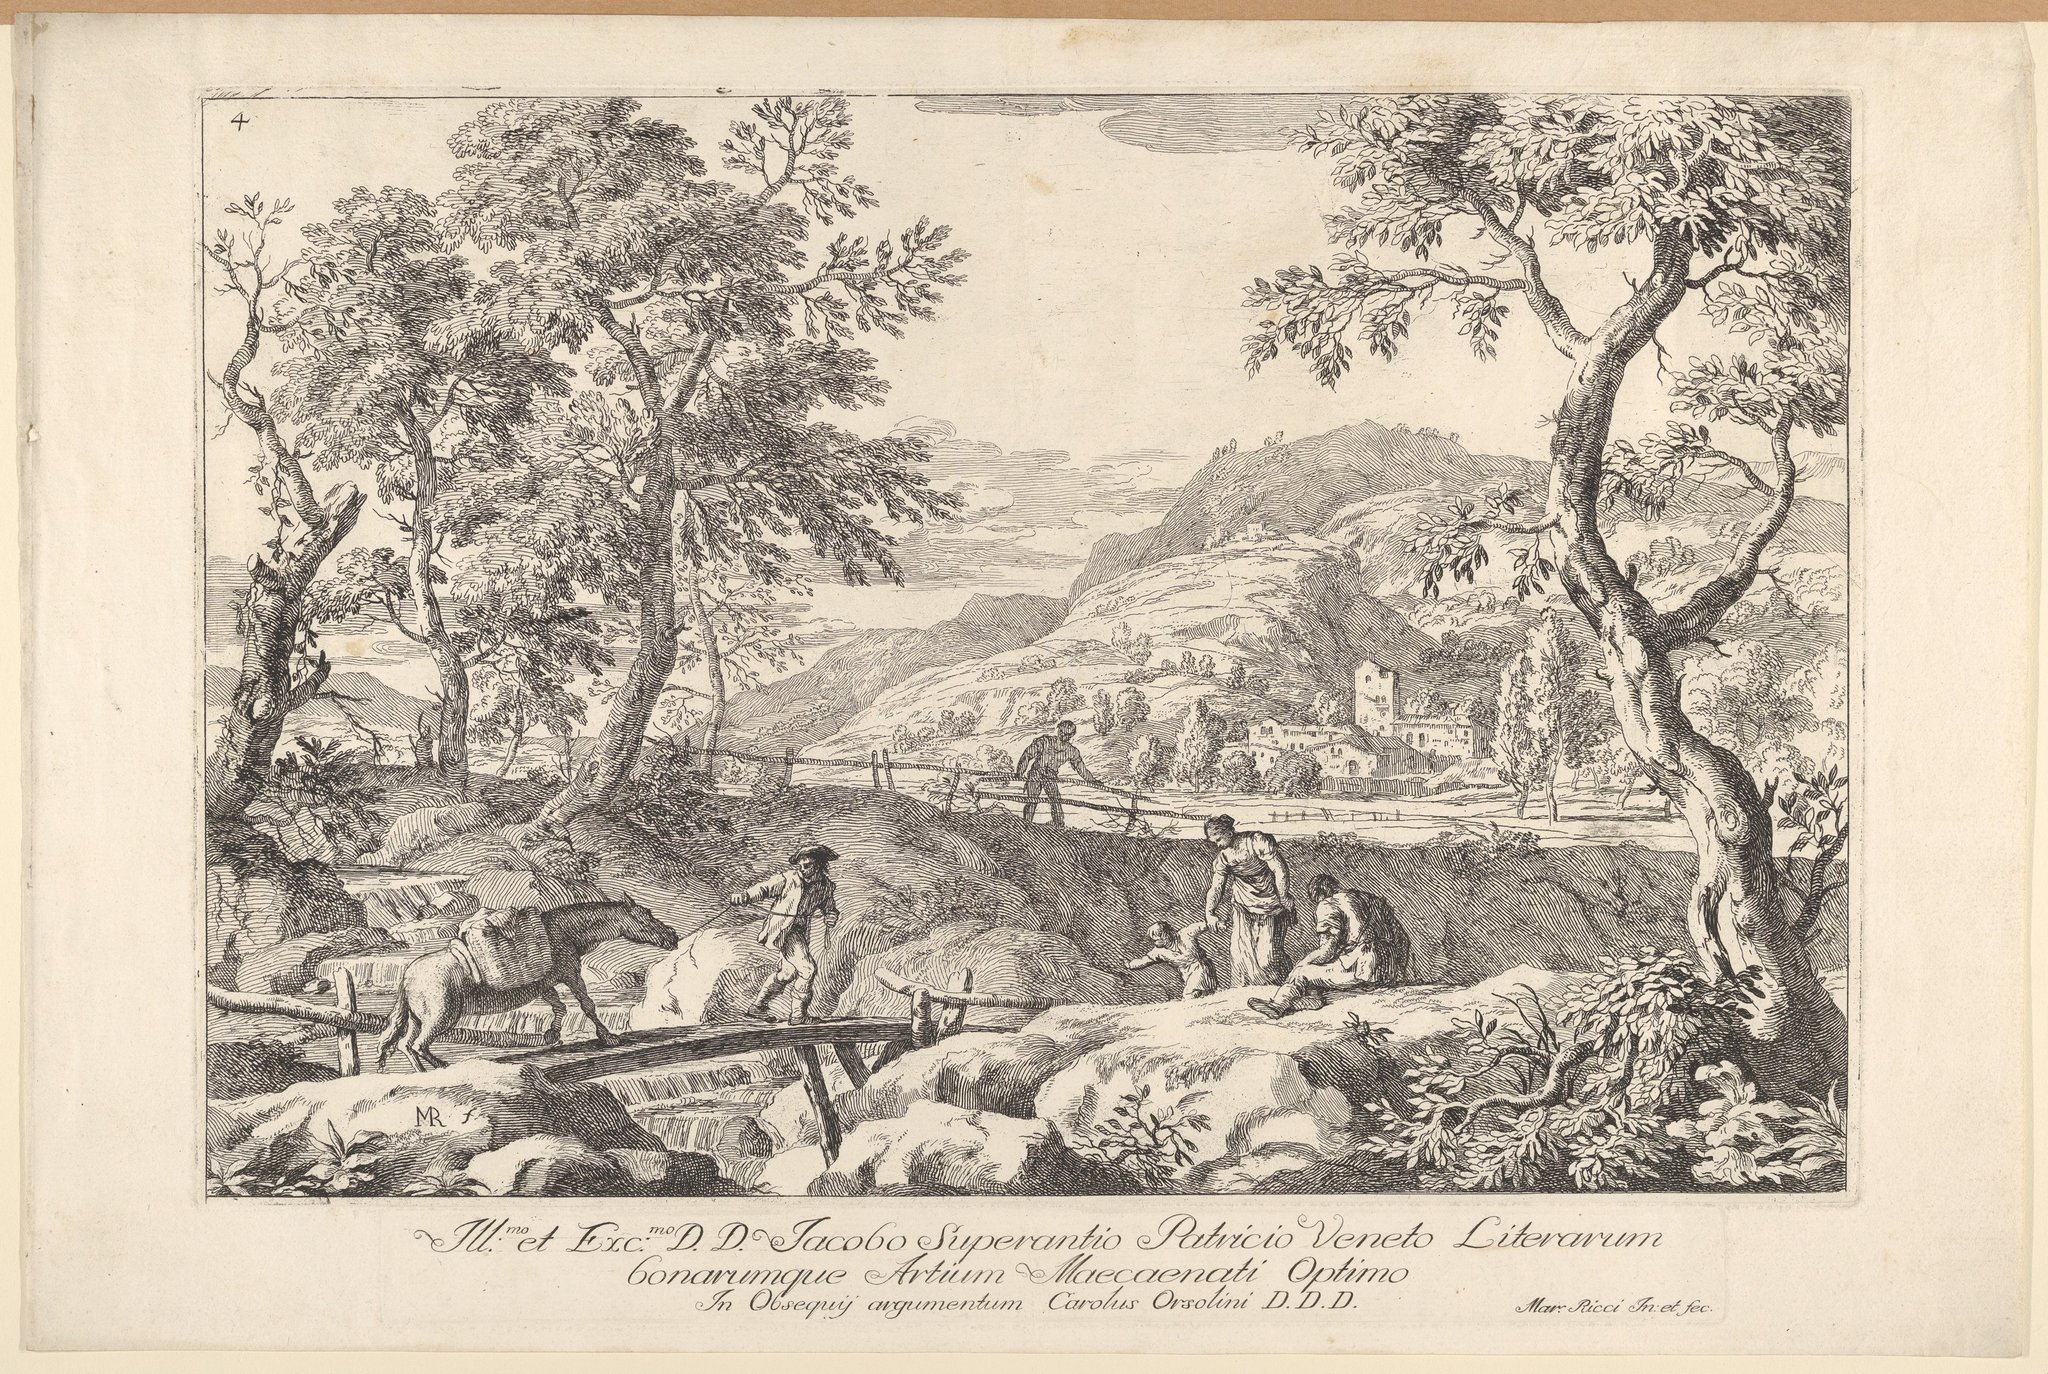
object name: print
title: Plate 4: Landscape with man leading a pack horse across a wooden bridge, three figures in right foreground, the silhouette of a man standing at a fence beyond, from "Landscapes"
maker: marco ricci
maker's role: artist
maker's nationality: italian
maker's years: 1676-1730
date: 1723-1730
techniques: etching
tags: bridges,men,women,horses,landscapes